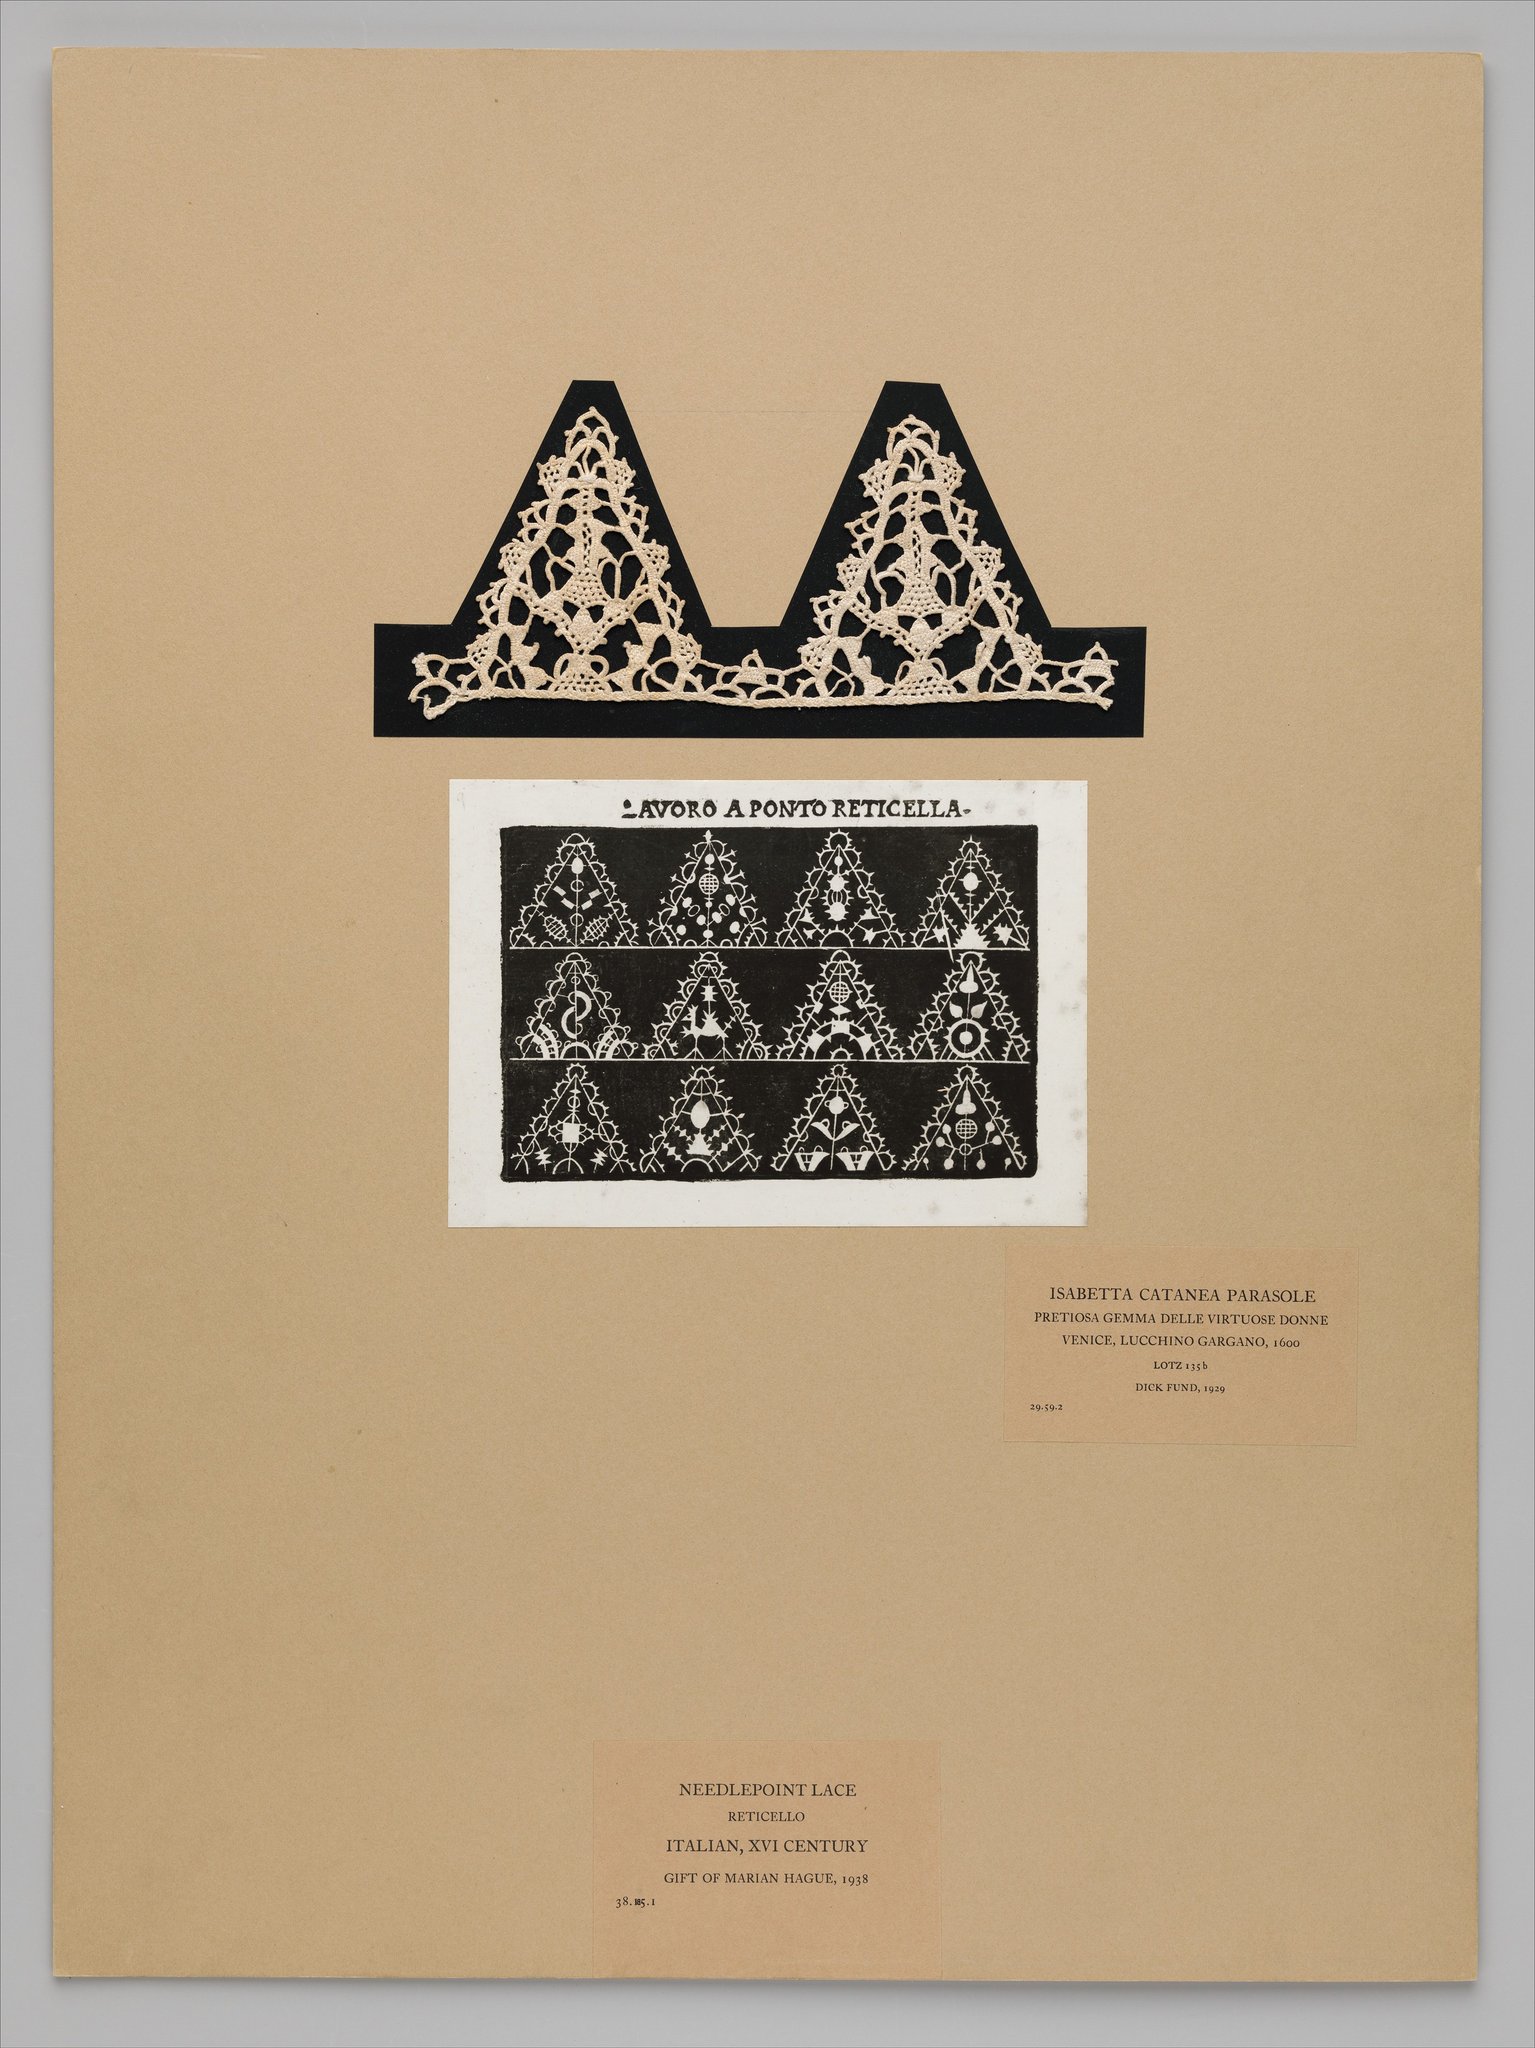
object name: edging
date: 1501-1600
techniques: lace